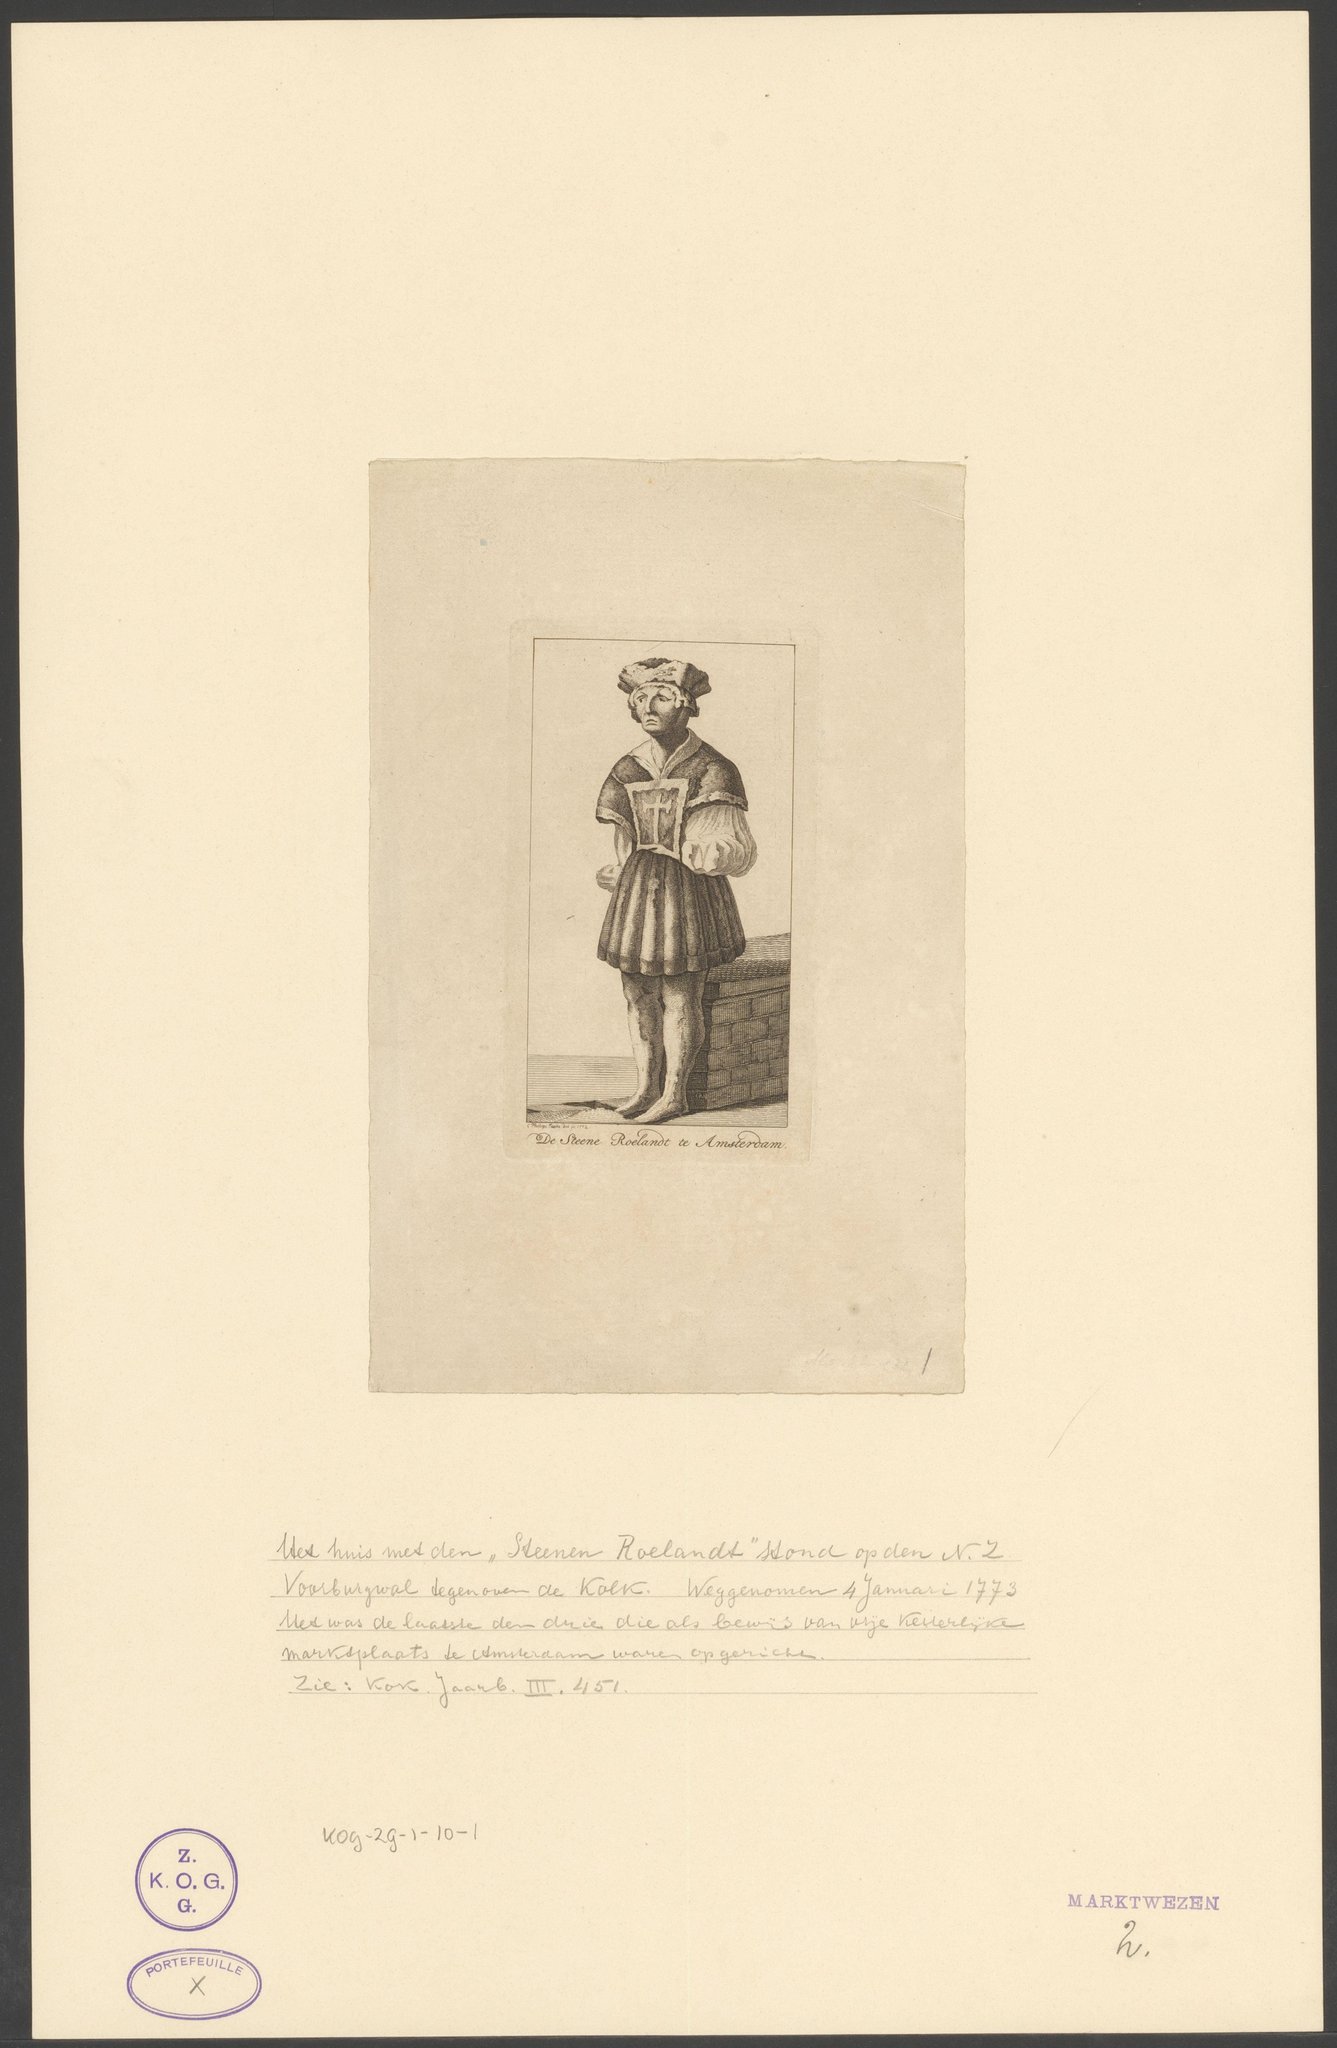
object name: print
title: Stenen Roelandt van het huis op de Nieuwezijds Voorburgwal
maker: caspar jacobsz. philips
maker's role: draughtsman, print maker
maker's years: 1732-1789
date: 1772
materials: paper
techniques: engraving, etching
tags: piece of sculpture, reproduction of a piece of sculpture, amsterdam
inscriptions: stamp:, collector's mark: Lugt 963, stamp:, collector's mark: Lugt 1641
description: Het beeld De Stenen Roelandt van het huis op Nieuwezijds Voorburgwal 52. Het beeld is verwijderd in 1773. Het beeld was de laatste van de drie beelden die de vrije ketterlijke marktplaats aanduidde. Onderwerpsrubrieken binnen de Atlas Zeden en Gewoonten: Handel, nijverheid en verkeer, Marktwezen, Amsterdam.